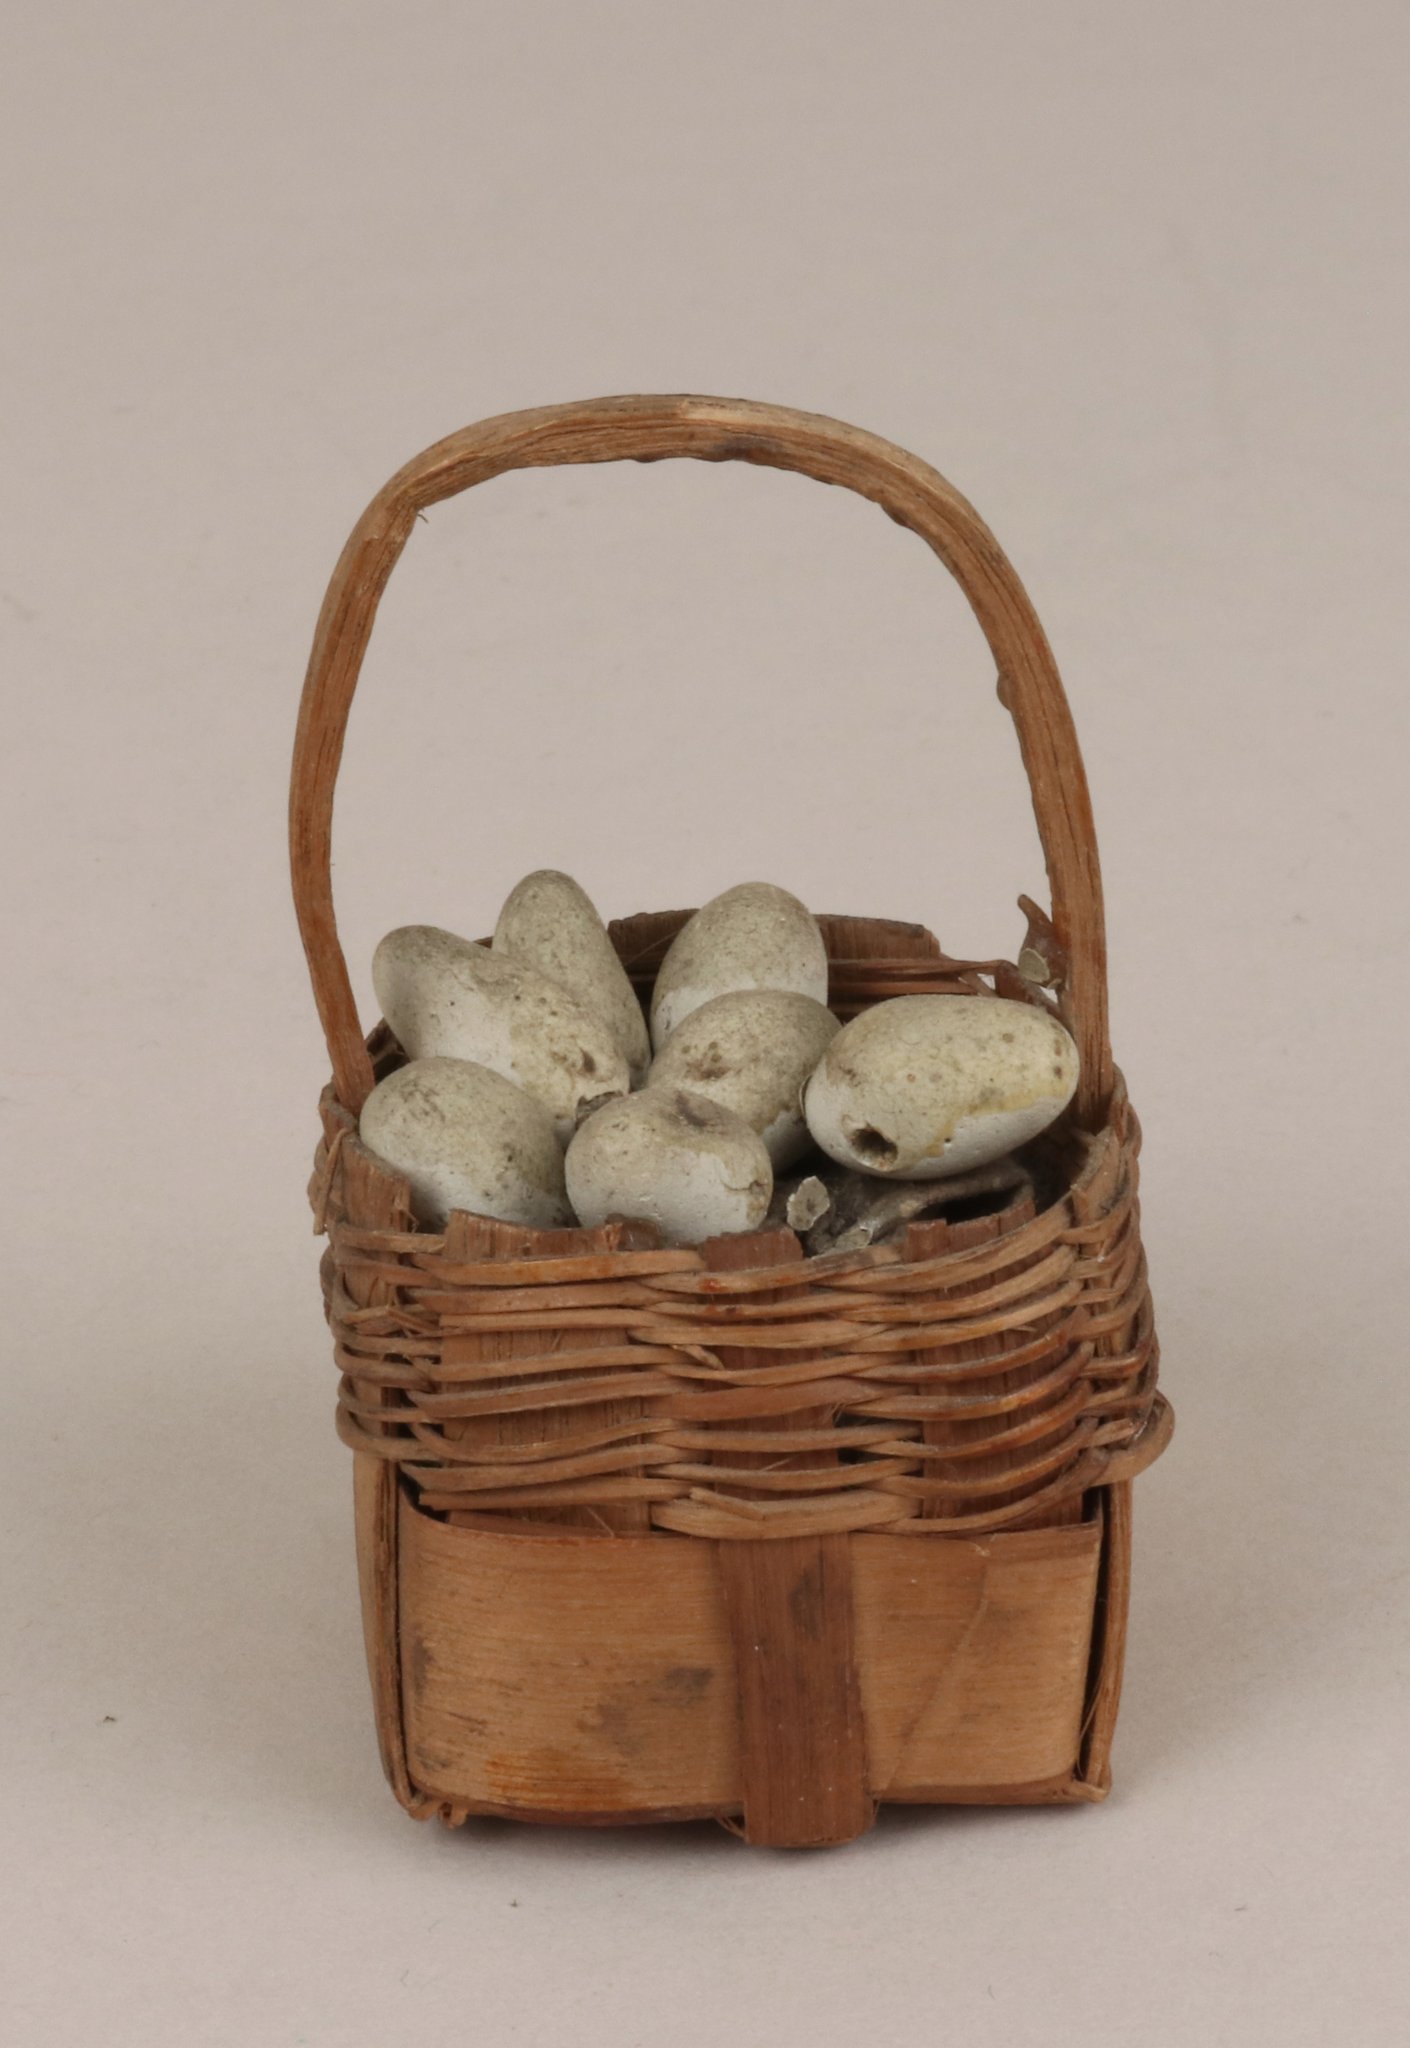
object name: crèche accessory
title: Basket of eggs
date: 1701-1800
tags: eggs